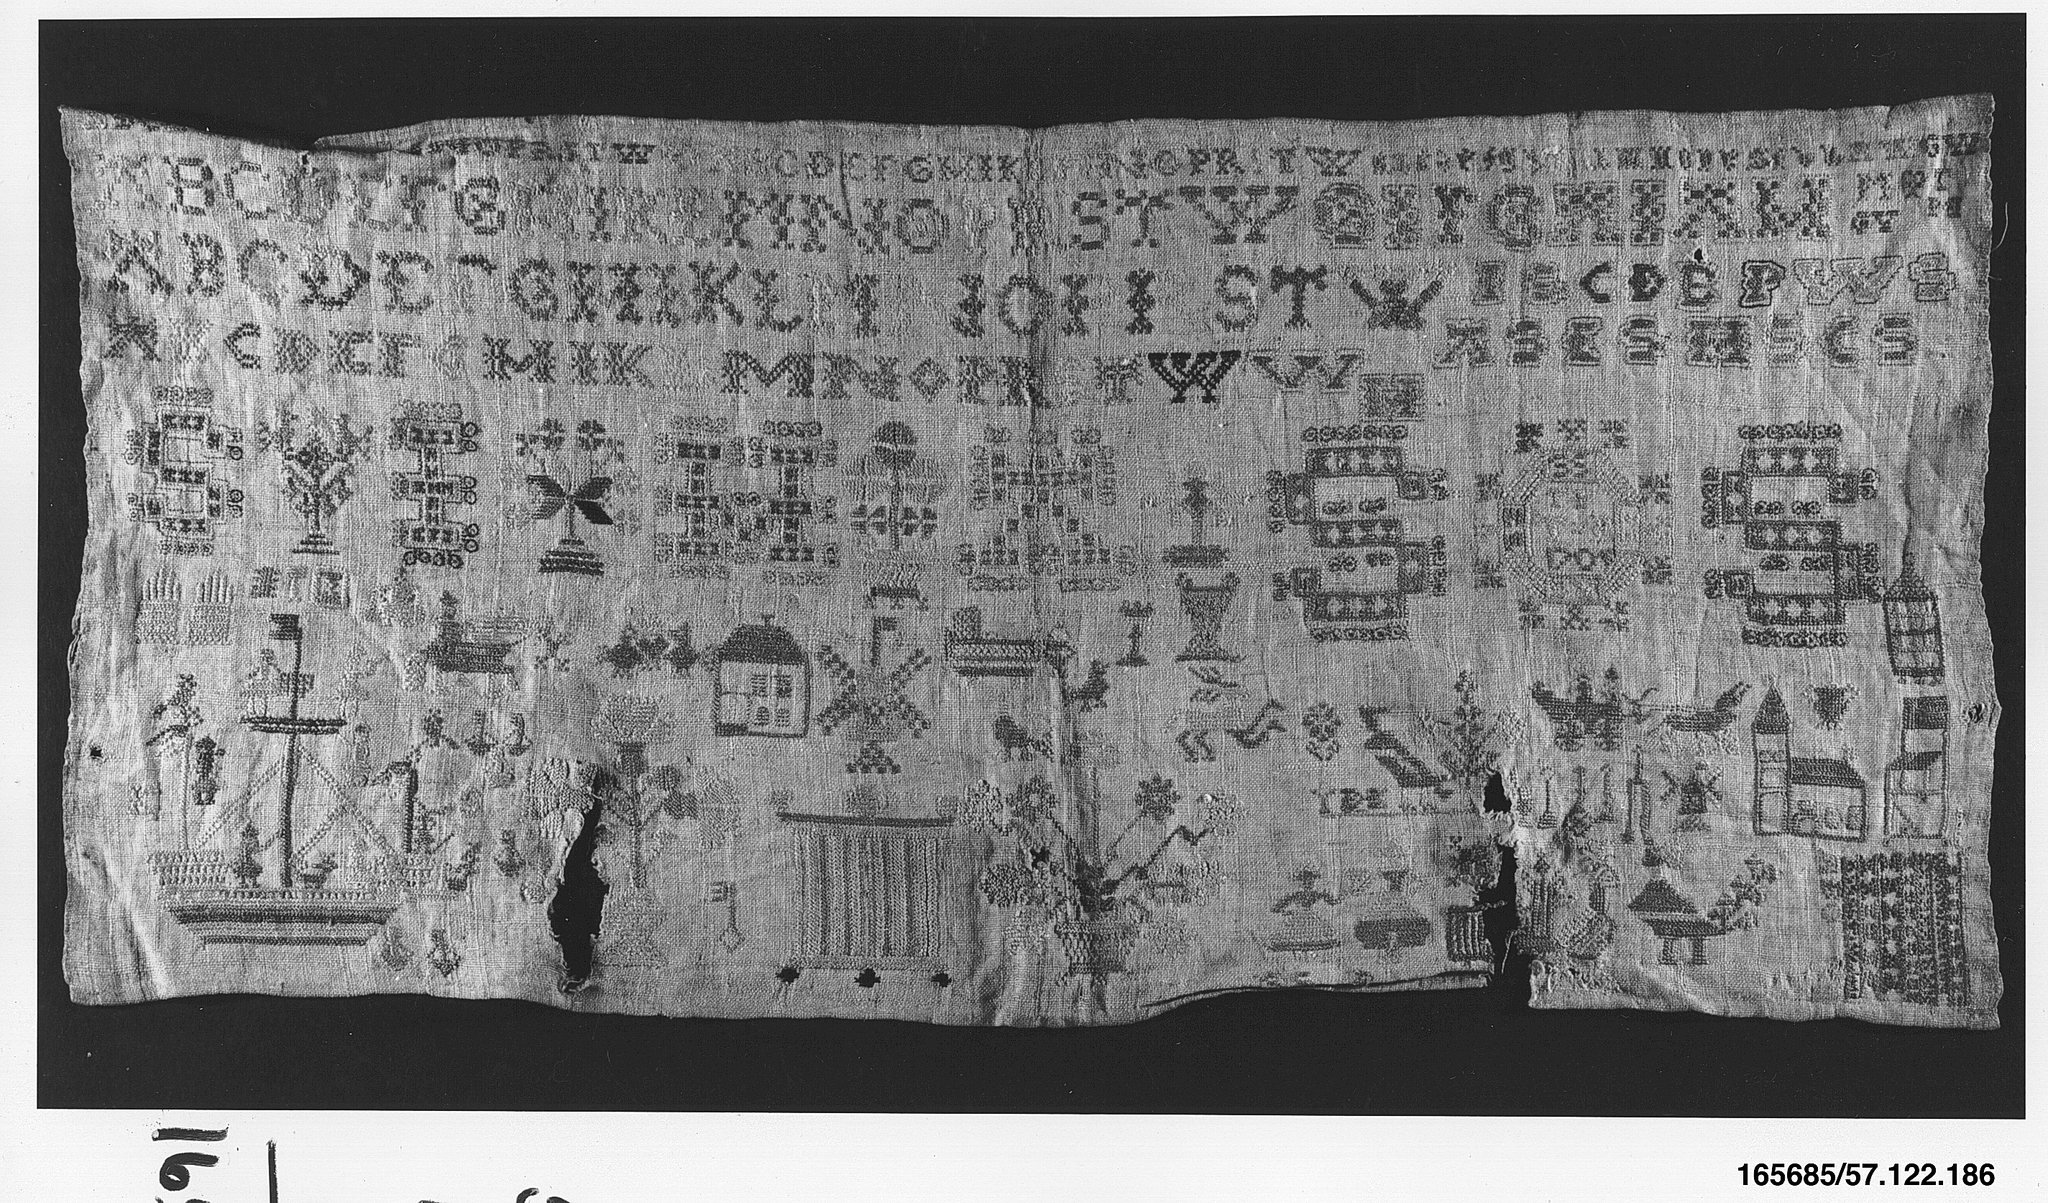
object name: sampler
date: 1704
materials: linen, silk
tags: birds,flowers,carriages